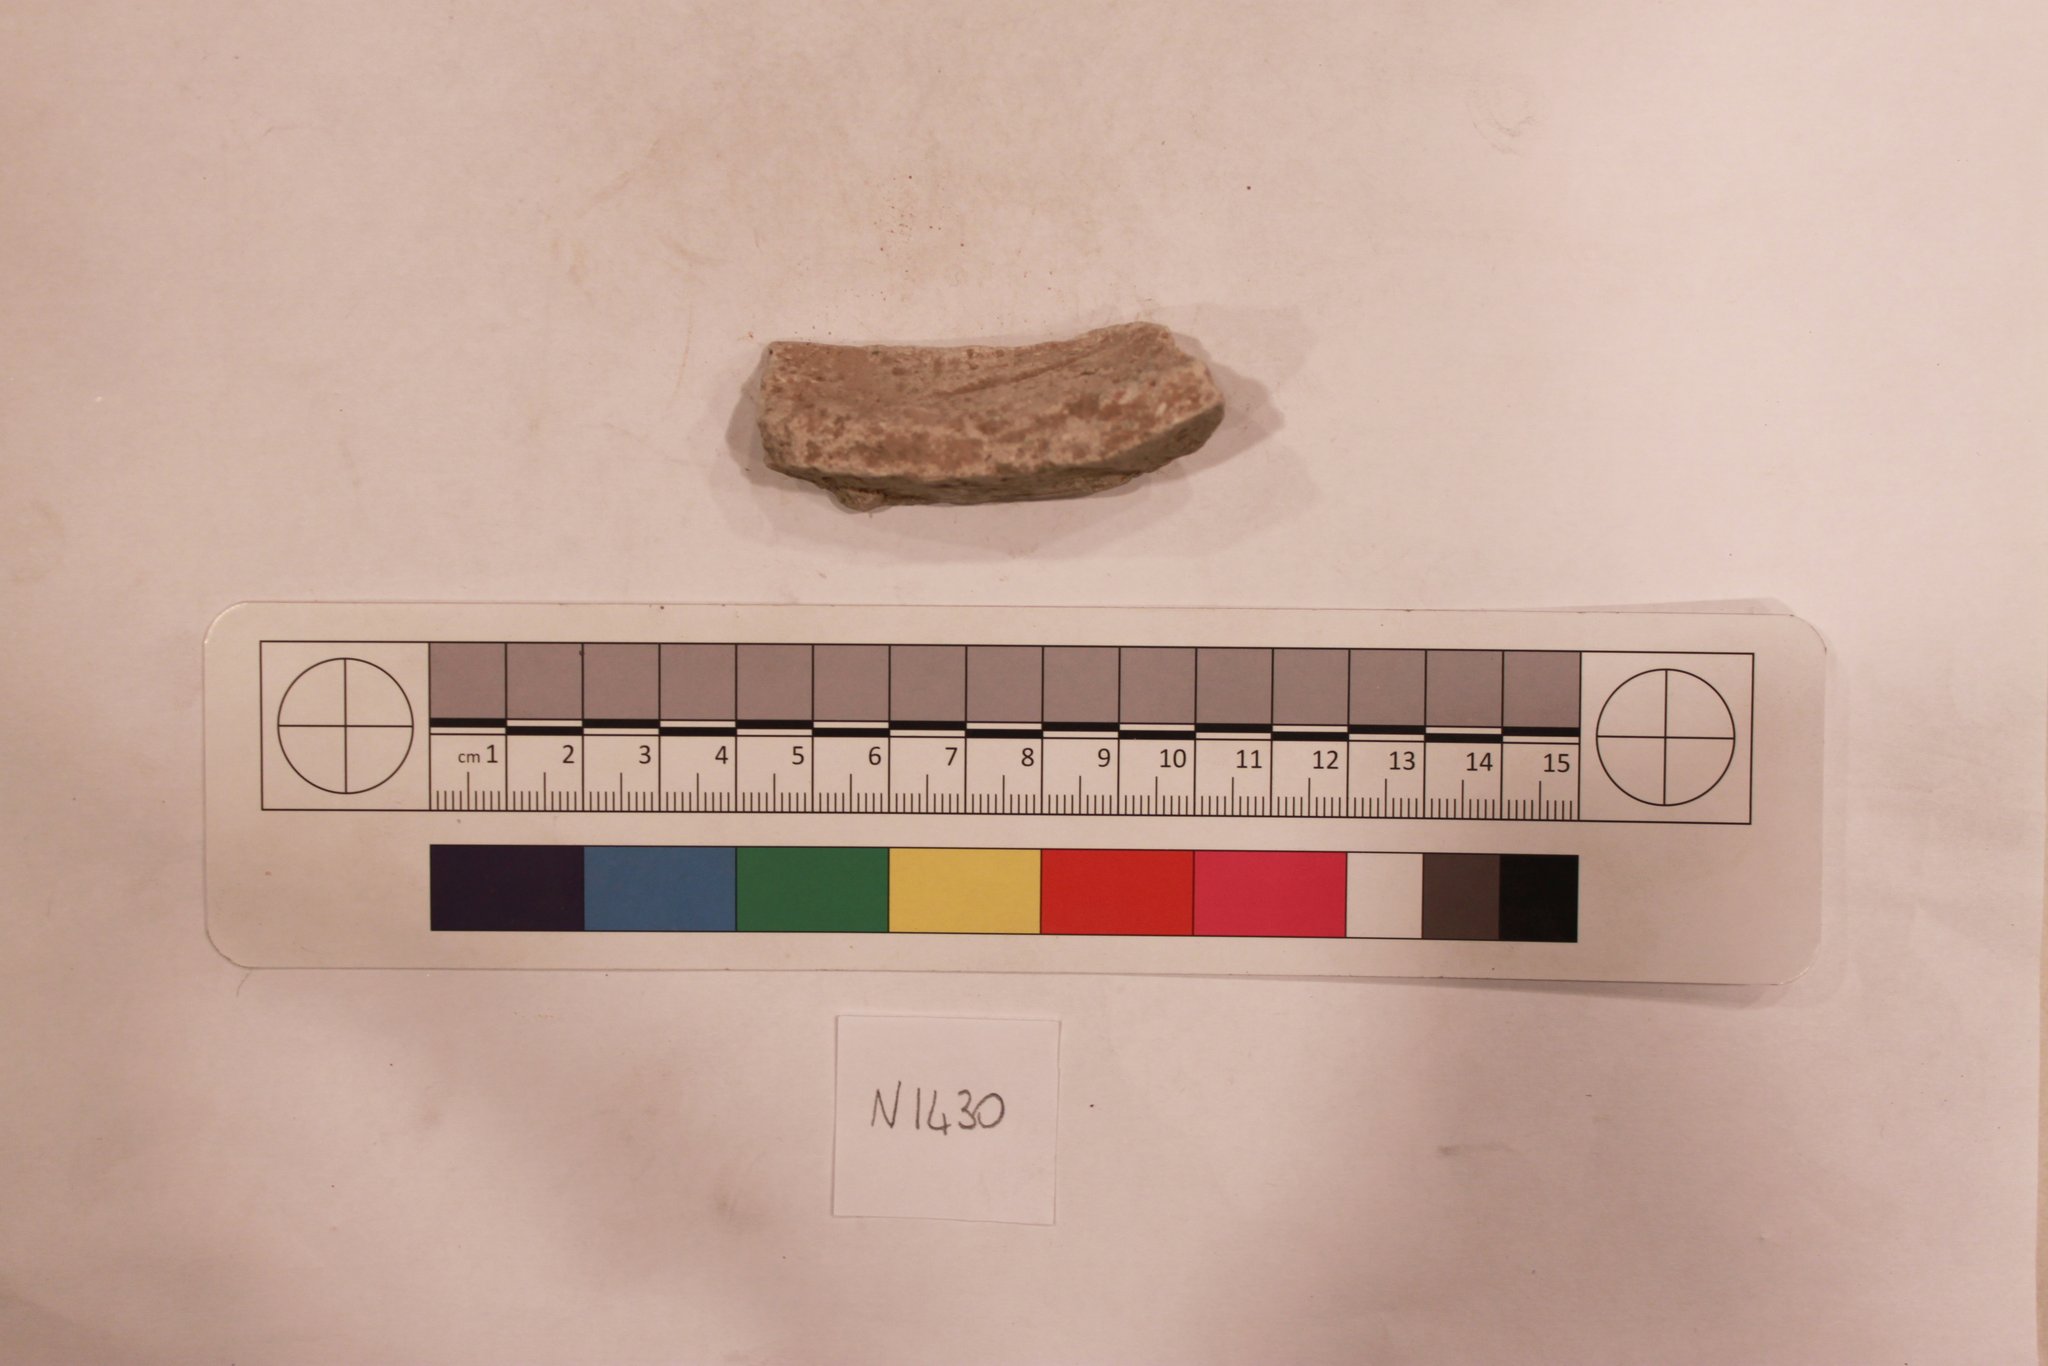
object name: fragment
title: Stucco Fragment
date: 701-1200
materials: plaster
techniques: carving, painting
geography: iran